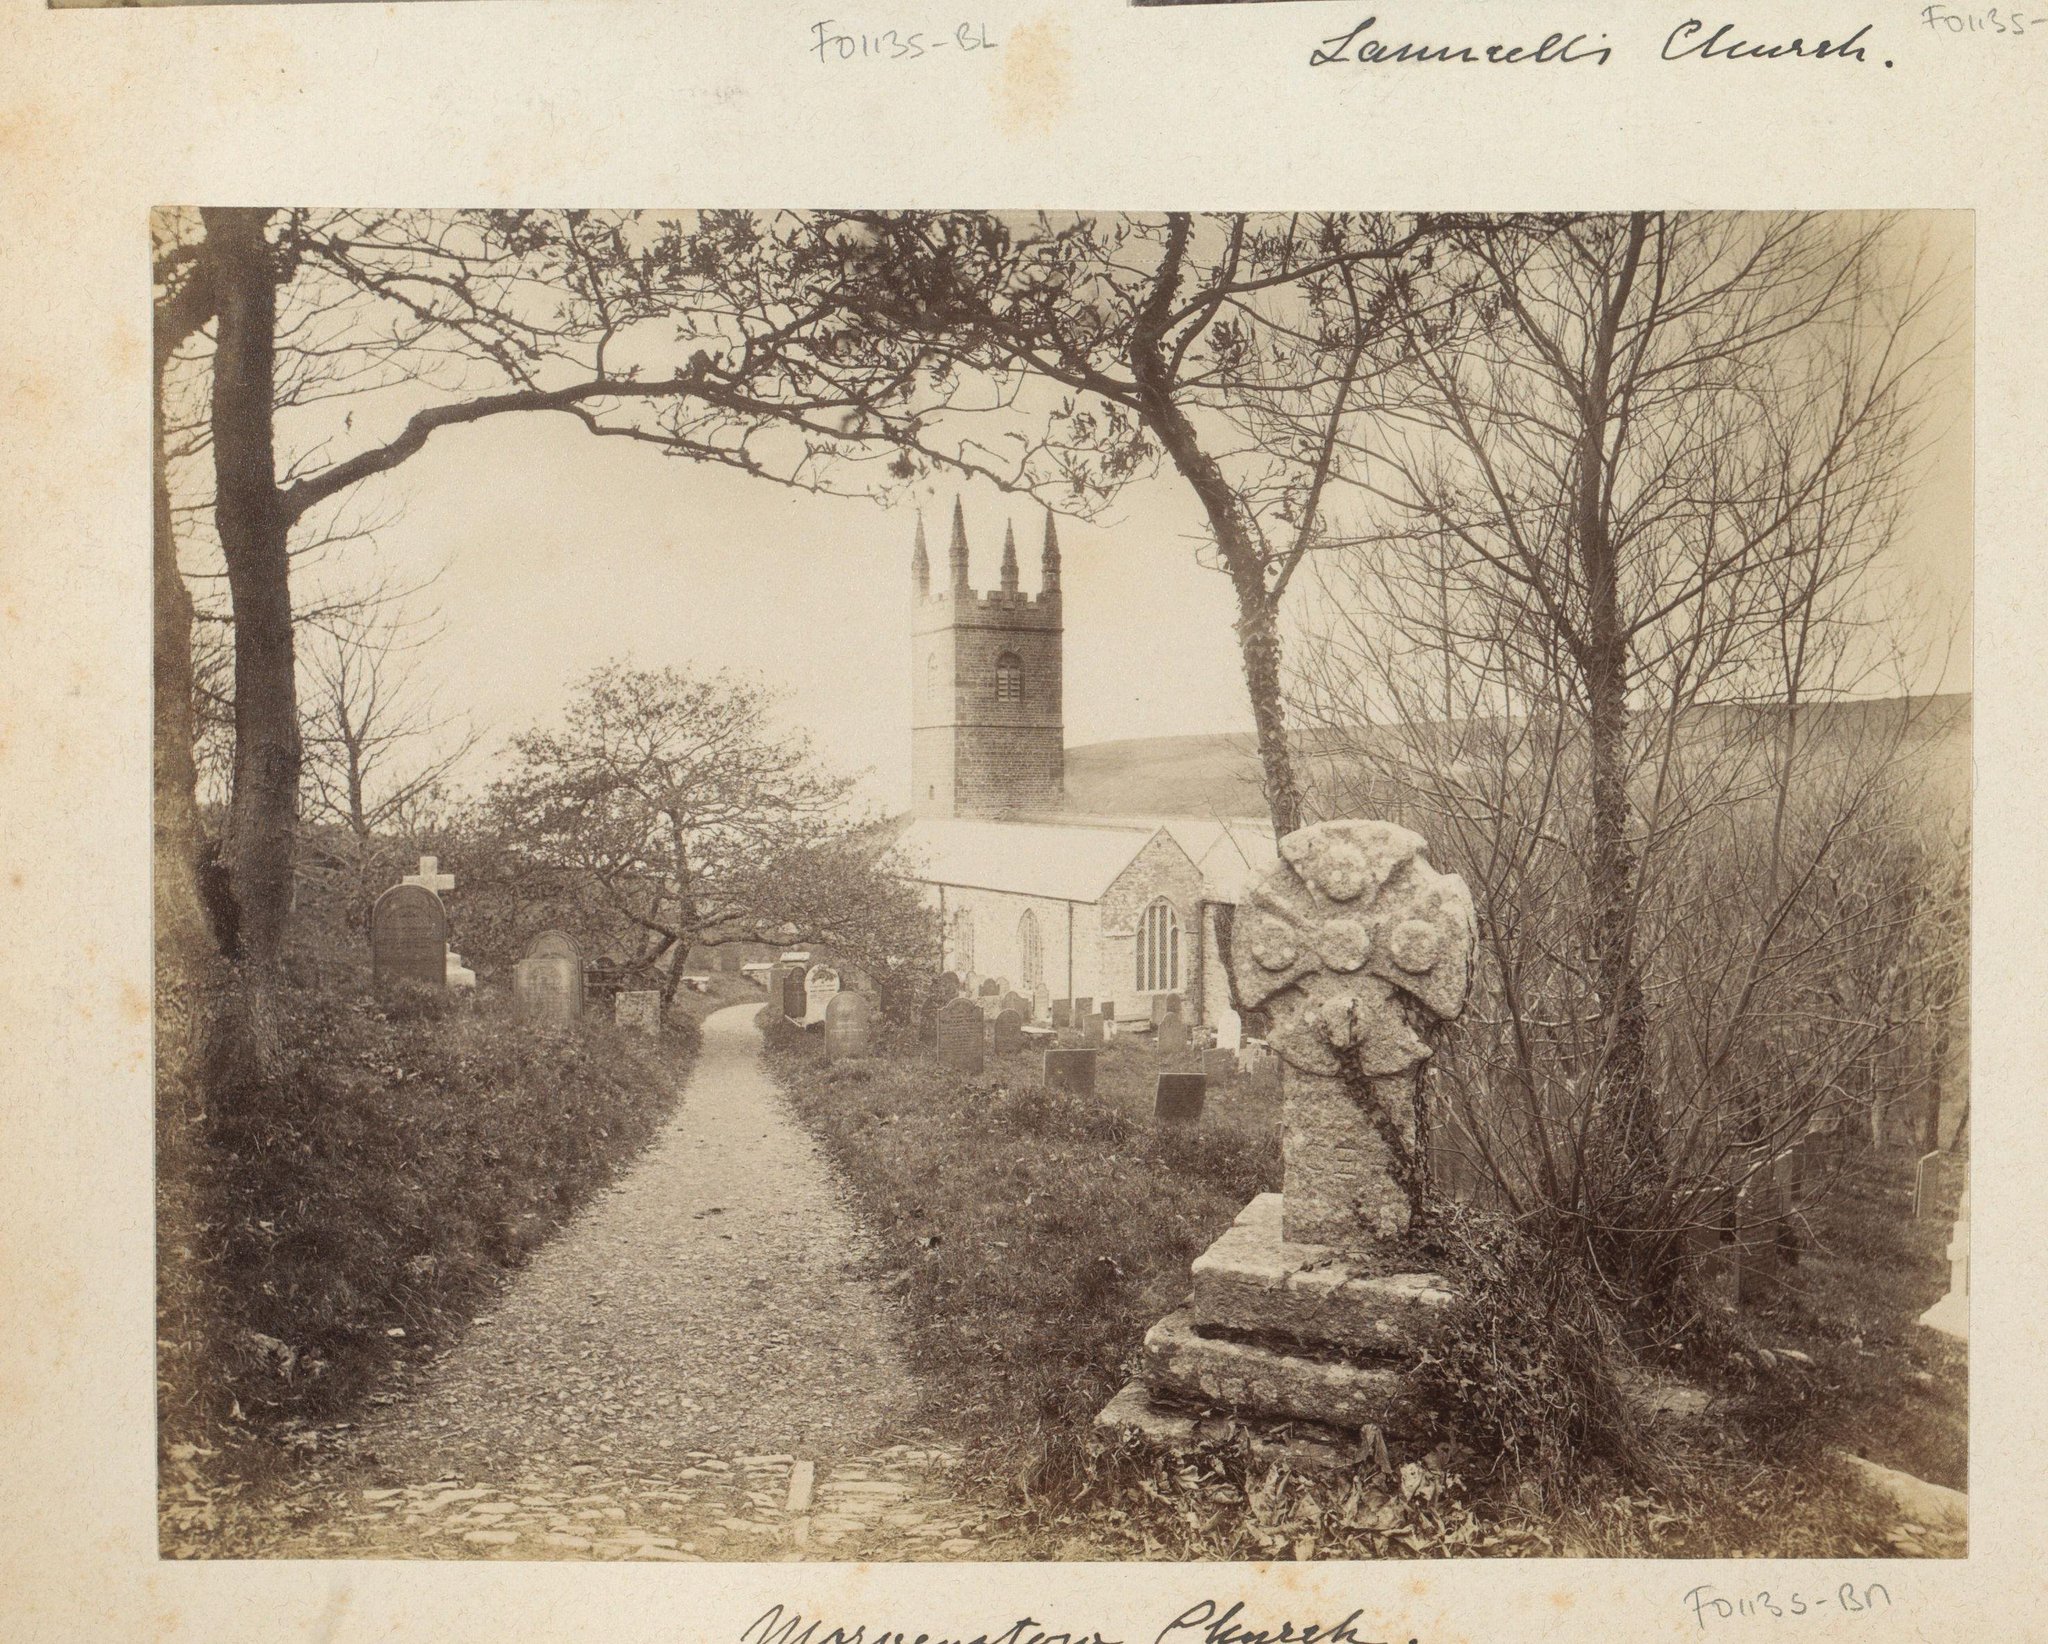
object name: photograph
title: Doopvont in St Swithin's Church in Launcells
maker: Anonymous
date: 1899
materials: paper, photographic support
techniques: daylight paper print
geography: launcells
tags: interior of church, baptismal font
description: Onderdeel van Reisalbum met foto's van bezienswaardigheden in Engeland en Frankrijk.